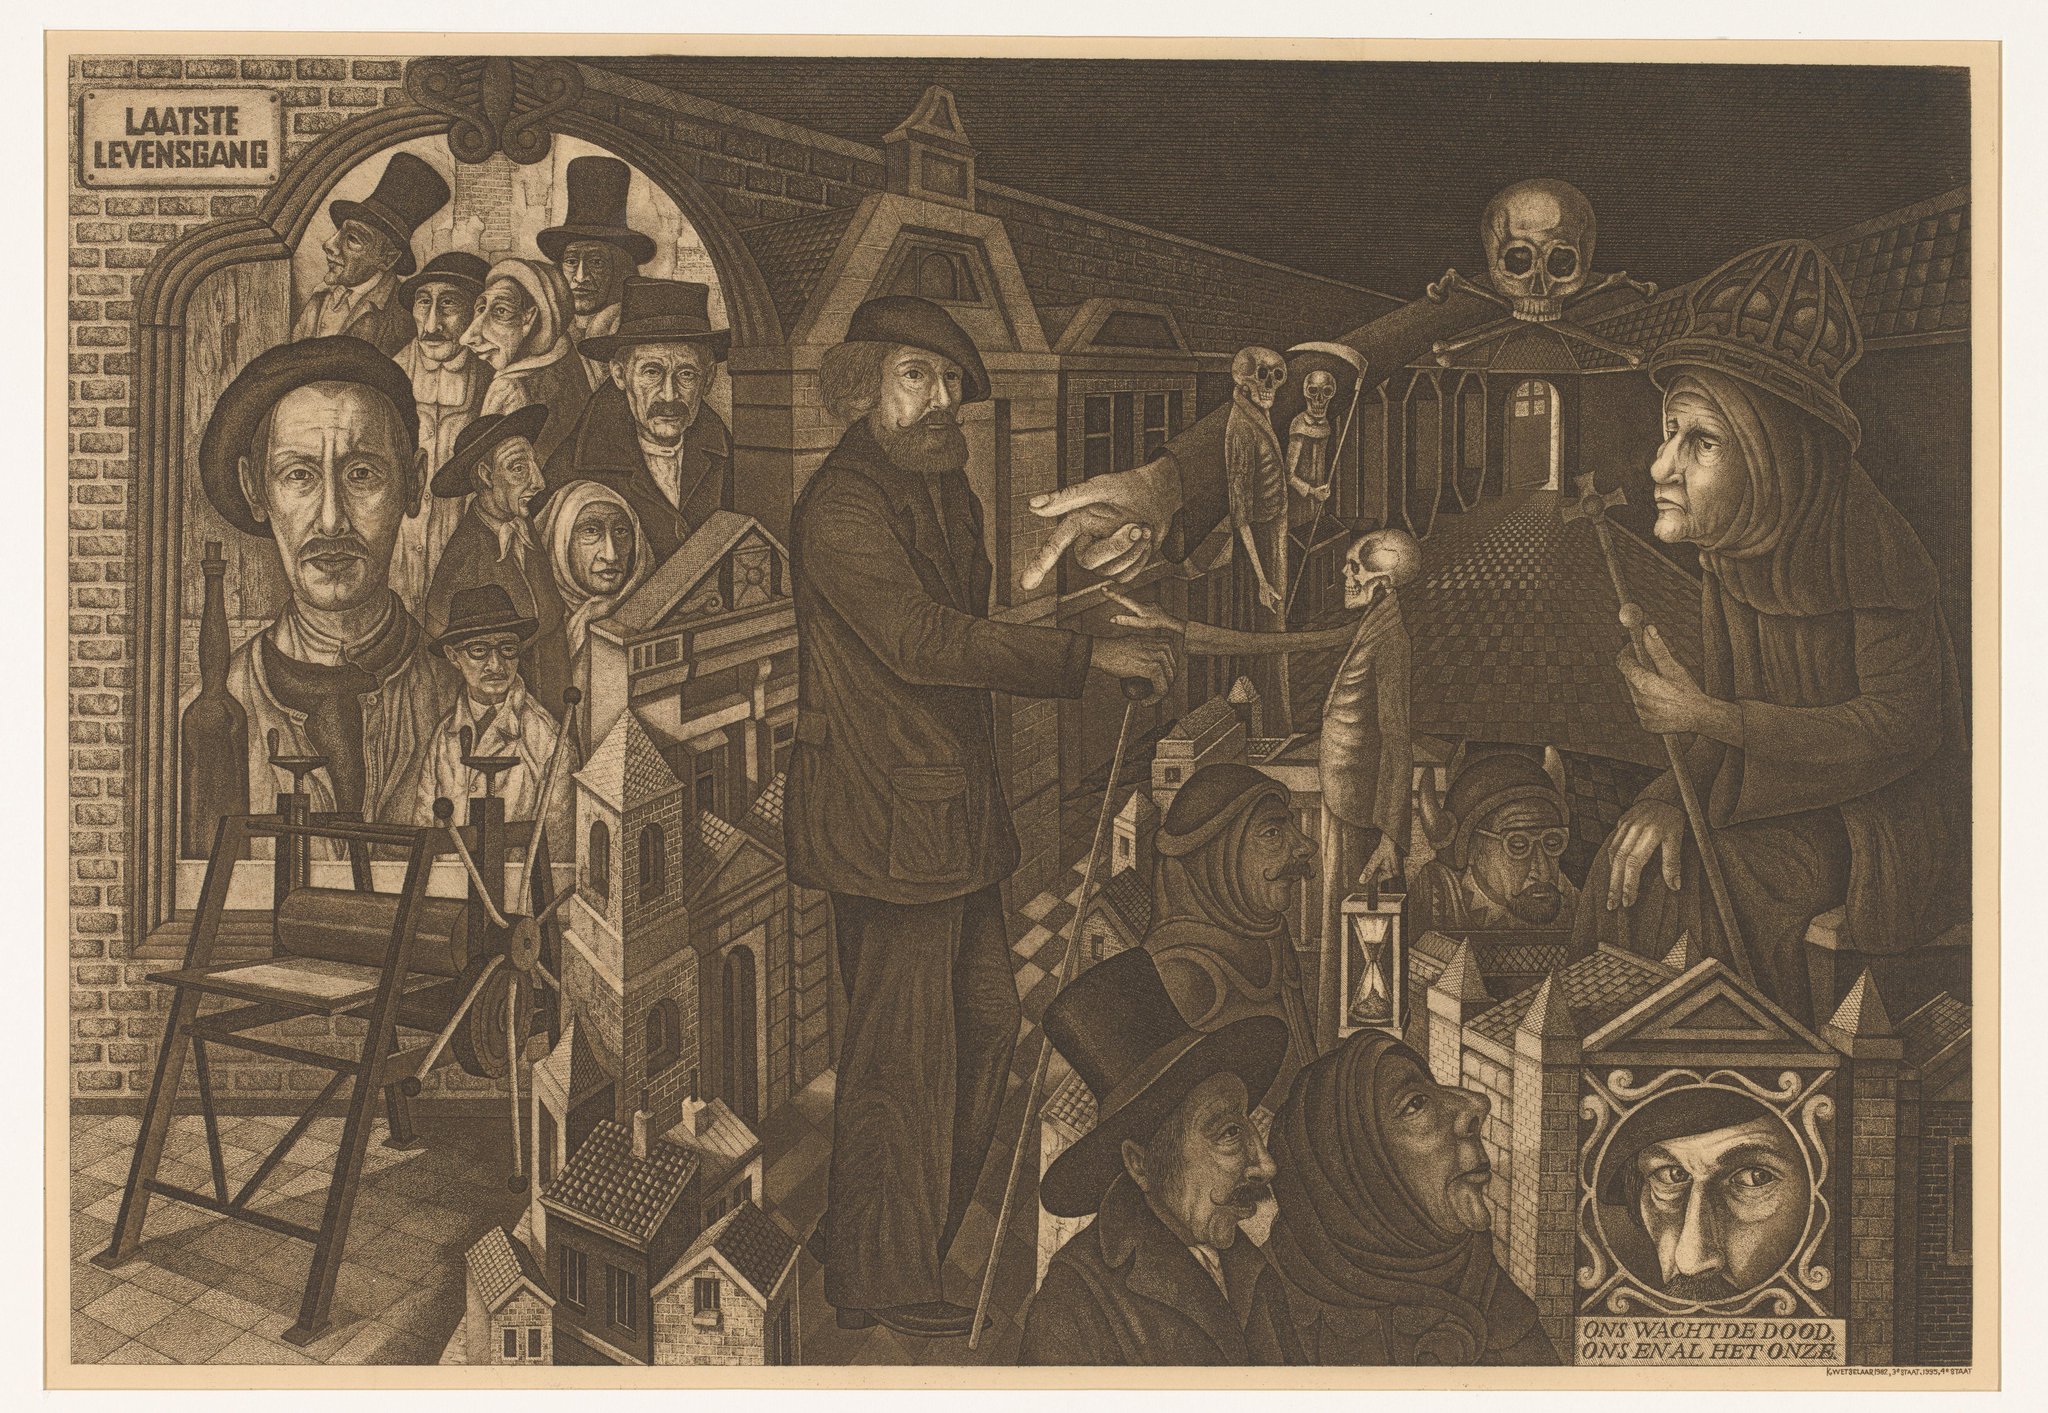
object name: print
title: Ons Wacht de Dood, Ons en Al het Onze.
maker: karel wetselaar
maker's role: print maker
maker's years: 1935-2017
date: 1982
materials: paper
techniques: etching, roulette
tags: hourglass, agricultural implements: sickle, death's head, skull (symbol of death)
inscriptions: signature and date: ‘K. Wetselaar 1982 1995’, inscription: ‘1982, 3e staat. 1995, 4e staat’